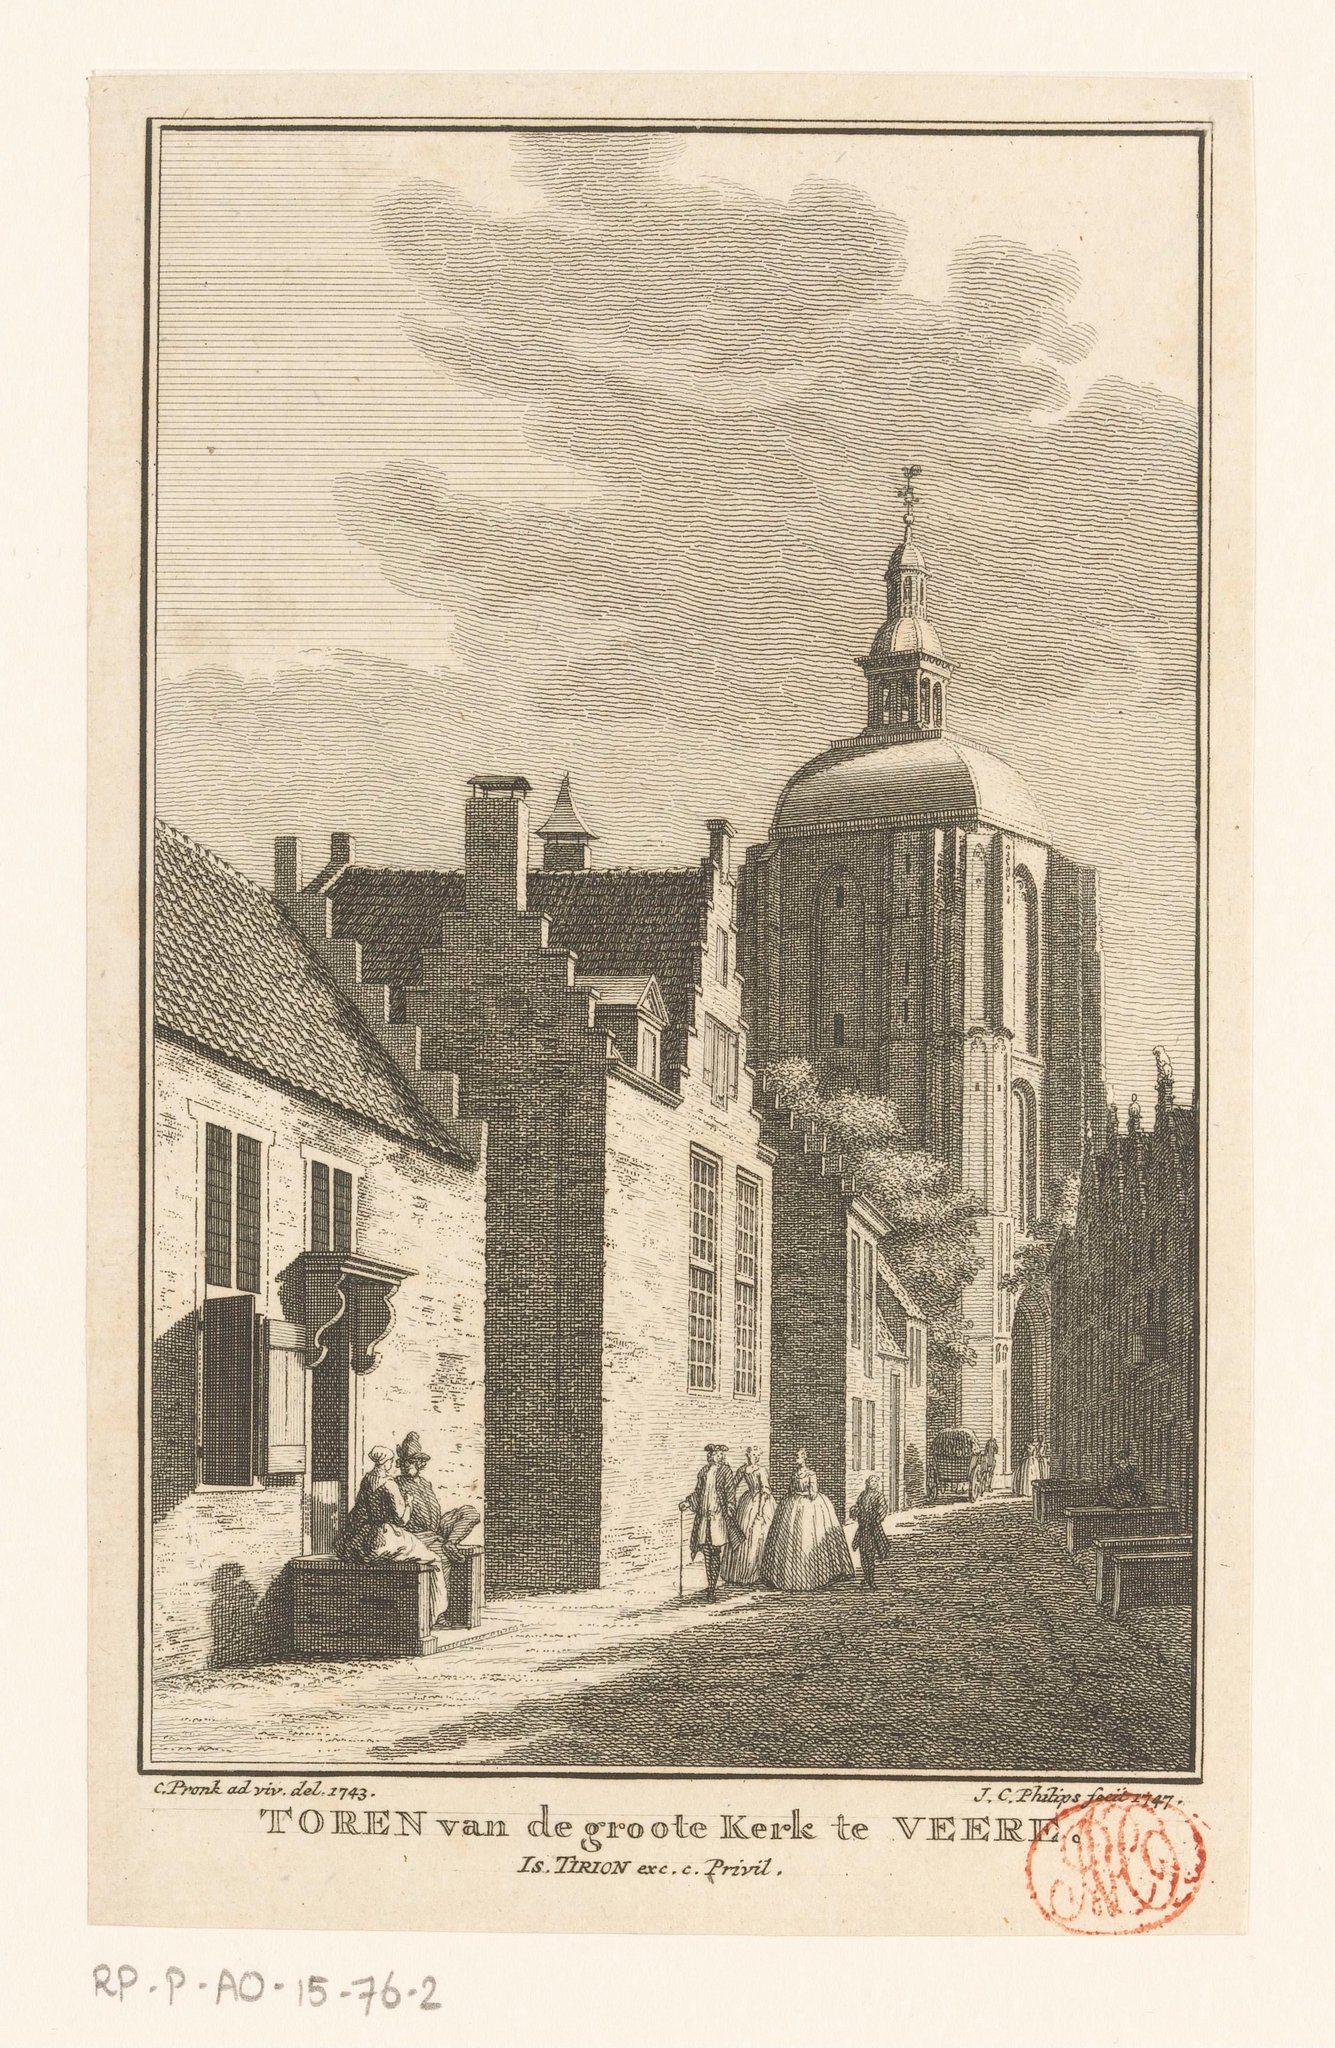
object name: print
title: Toren van de groote Kerk te Veere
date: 1747-1760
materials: paper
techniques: etching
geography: amsterdam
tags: church (exterior), parts of church exterior and annexes: tower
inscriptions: collector's mark: Lugt 195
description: Gezicht op de toren van de Grote Kerk te Veere, gezien vanuit de Wijngaardstraat, in de situatie omstreeks 1743.